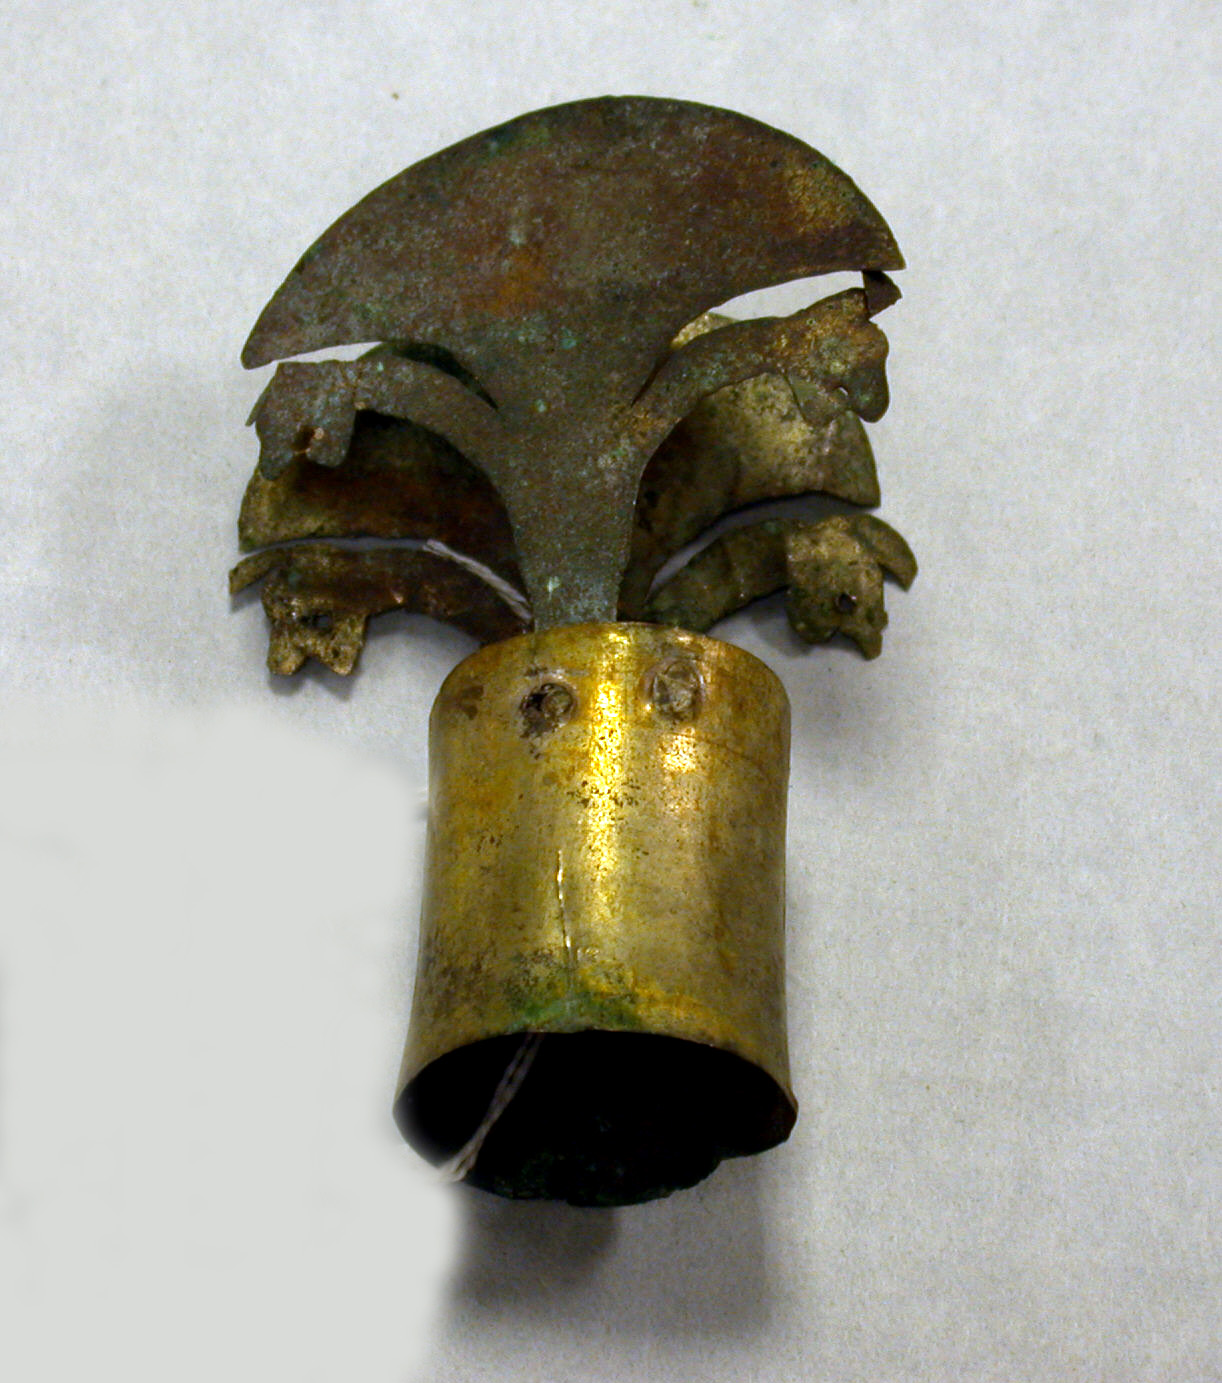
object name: crown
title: Hammered Silver Miniature Crown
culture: peruvian, north or central coast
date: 1001-1566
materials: gilt, silver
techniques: hammering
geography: peru